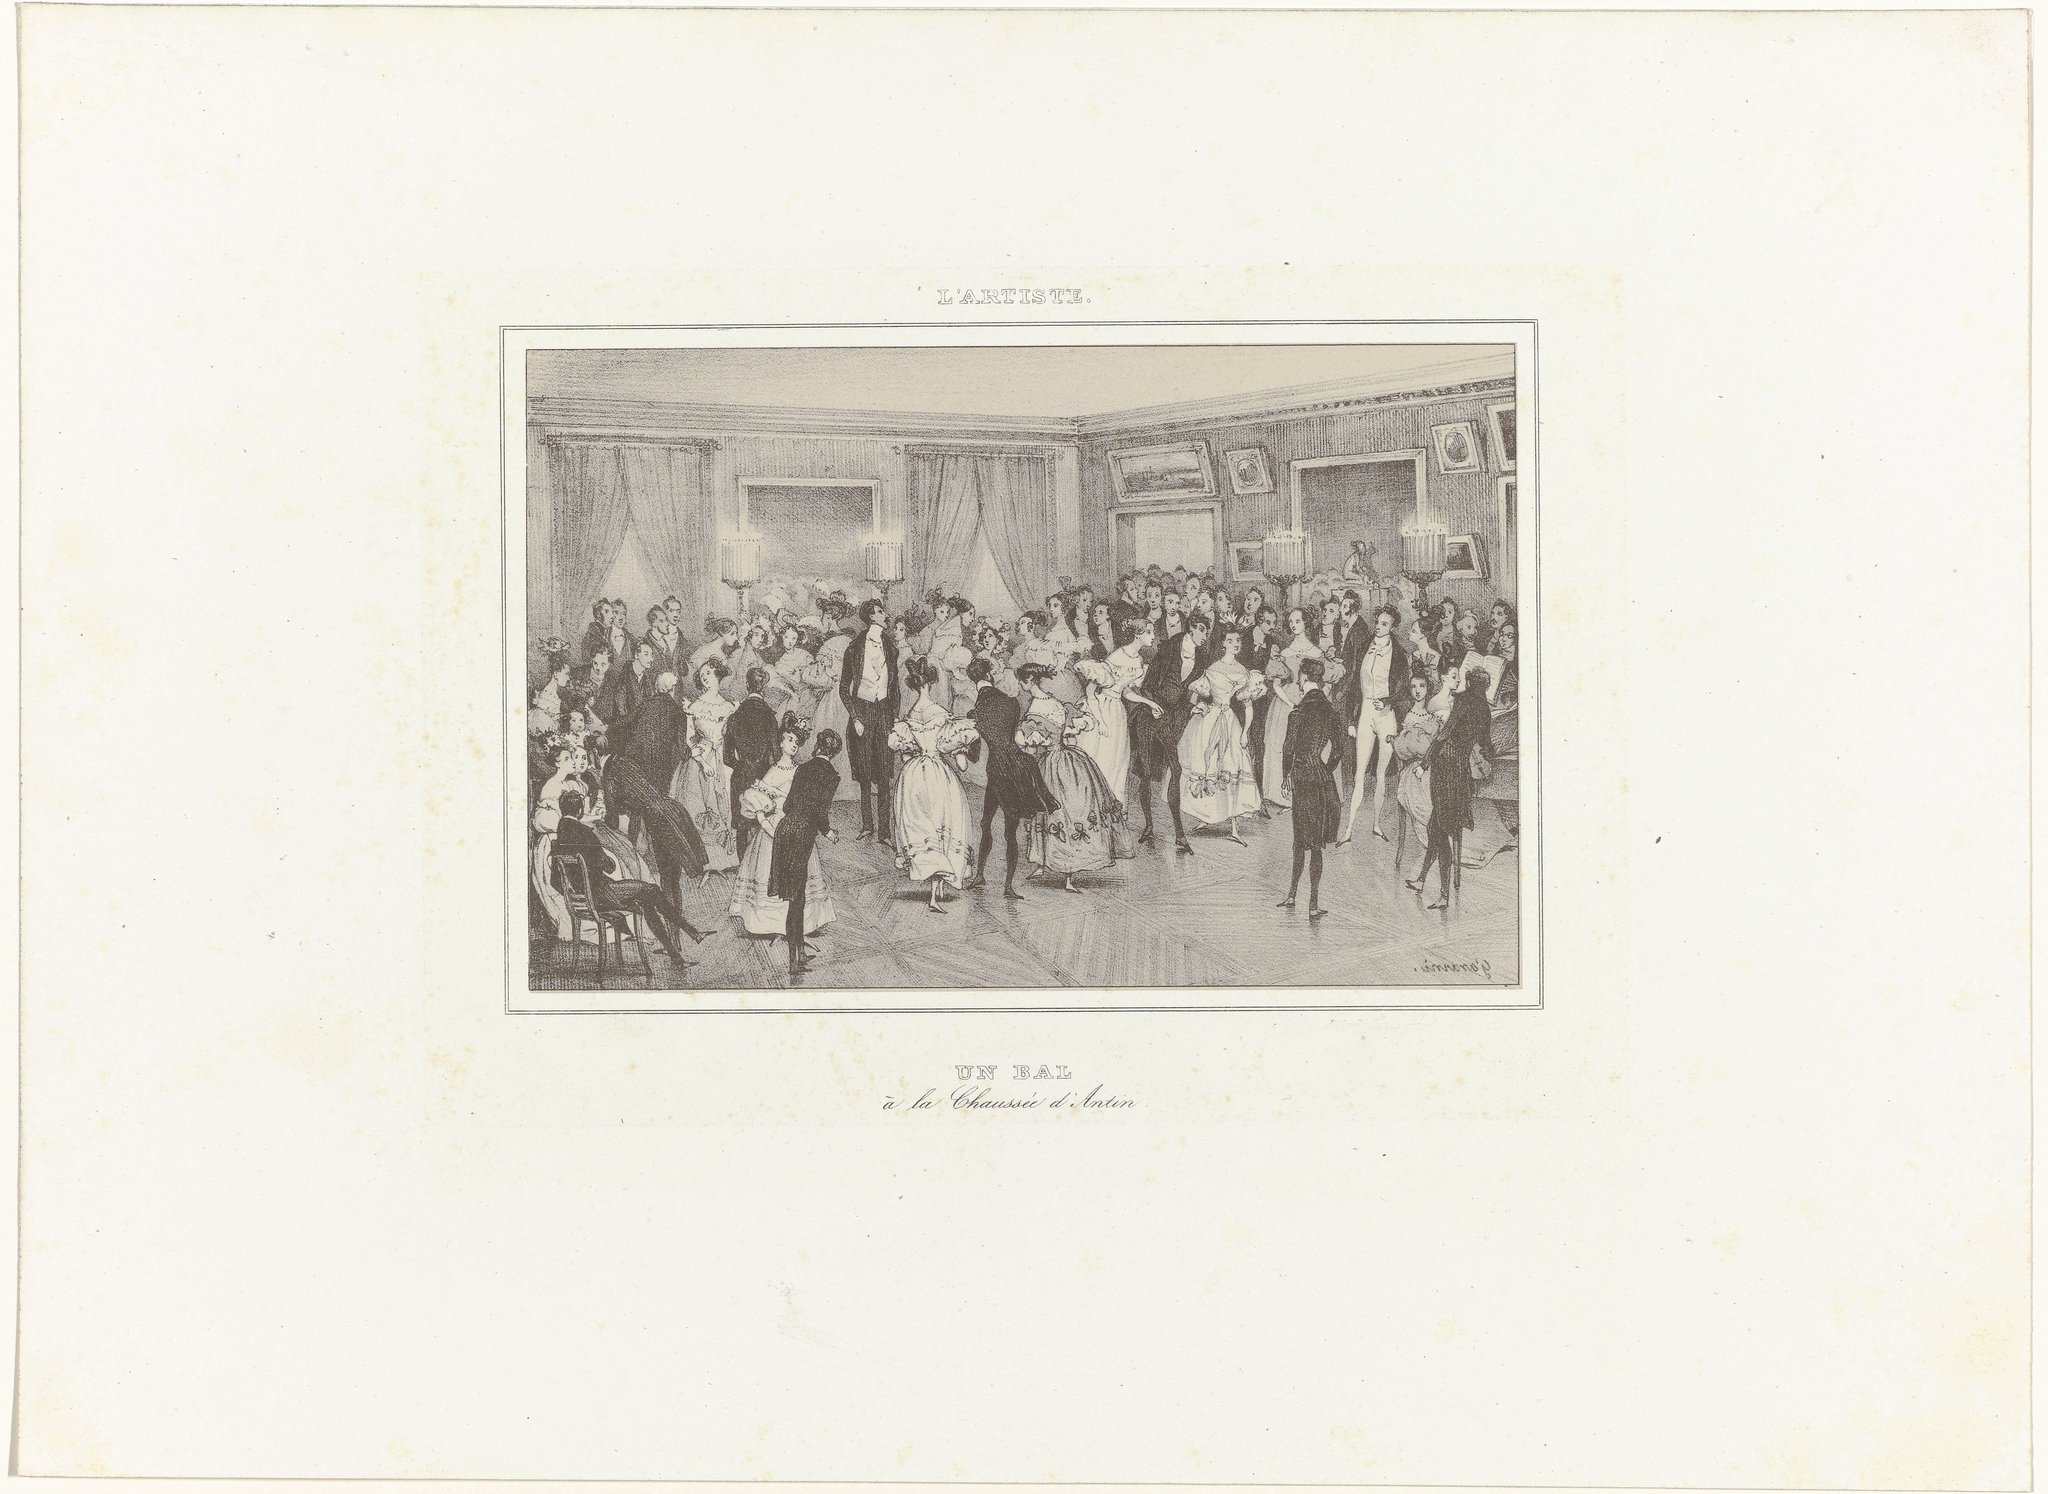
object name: print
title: L'Artiste, 1835 : Un Bal à la Chaussée d'Antin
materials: paper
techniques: engraving, lithograph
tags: party clothes, festive attire (+ women's clothes), party clothes, festive attire (+ men's clothes), ball, formal dance, fashion plates, more than one couple dancing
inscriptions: title: ‘L'ARTISTE.’, caption: ‘UN BAL / à la Chaussée d'Antin’